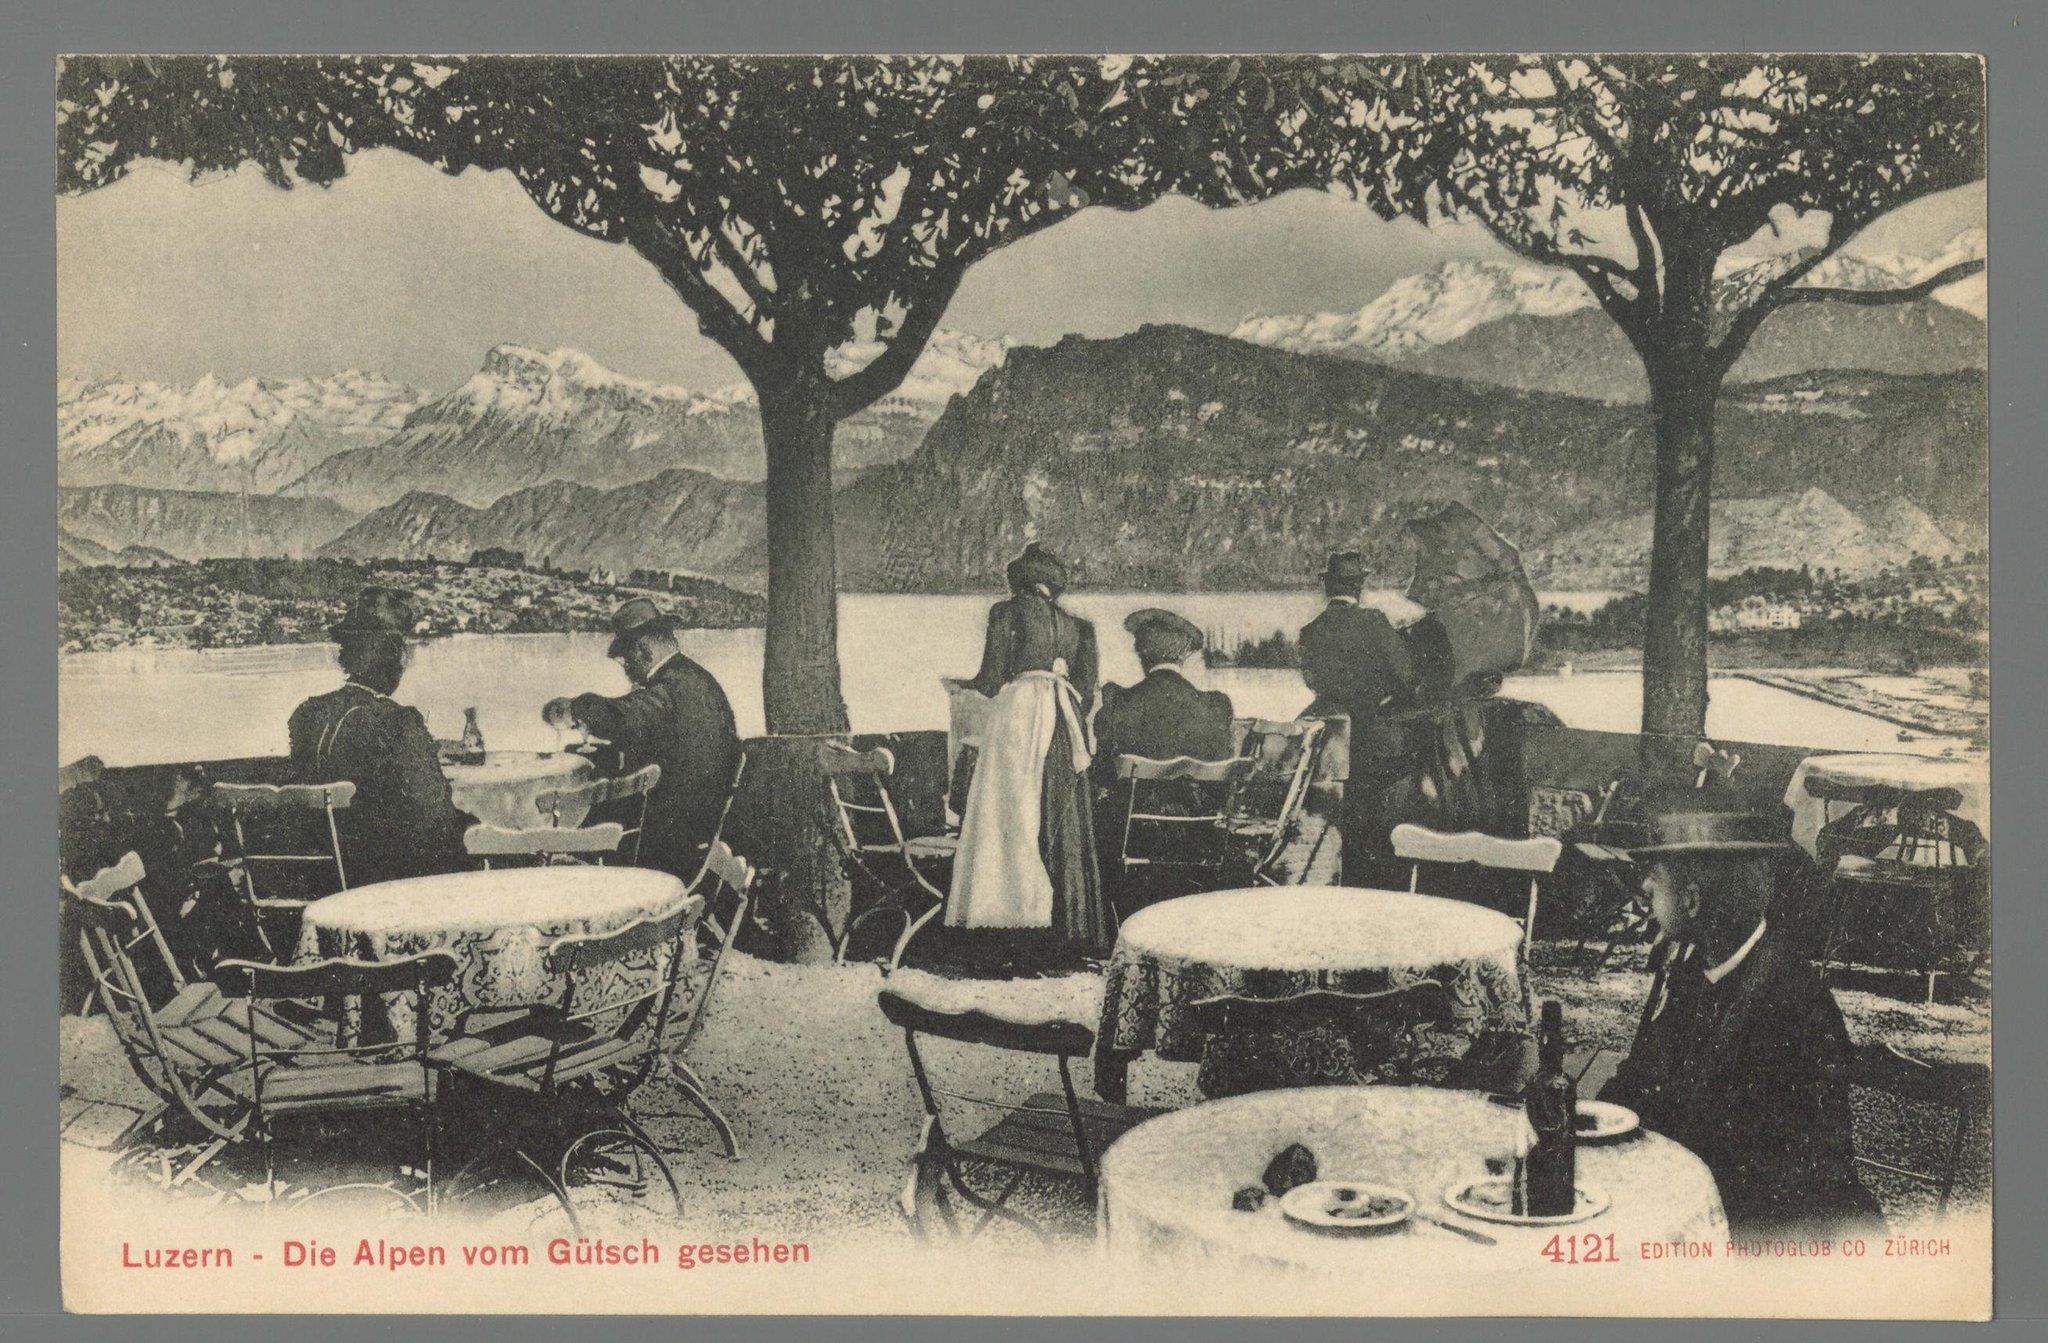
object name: ansichtkaart, prentbriefkaart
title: Luzern. Die Alpen vom Gütsch gesehen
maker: Anonymous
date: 1895-1905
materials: cardboard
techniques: photograph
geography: lucerne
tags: lake, tea garden, garden restaurant, mountain-range, snow peaks